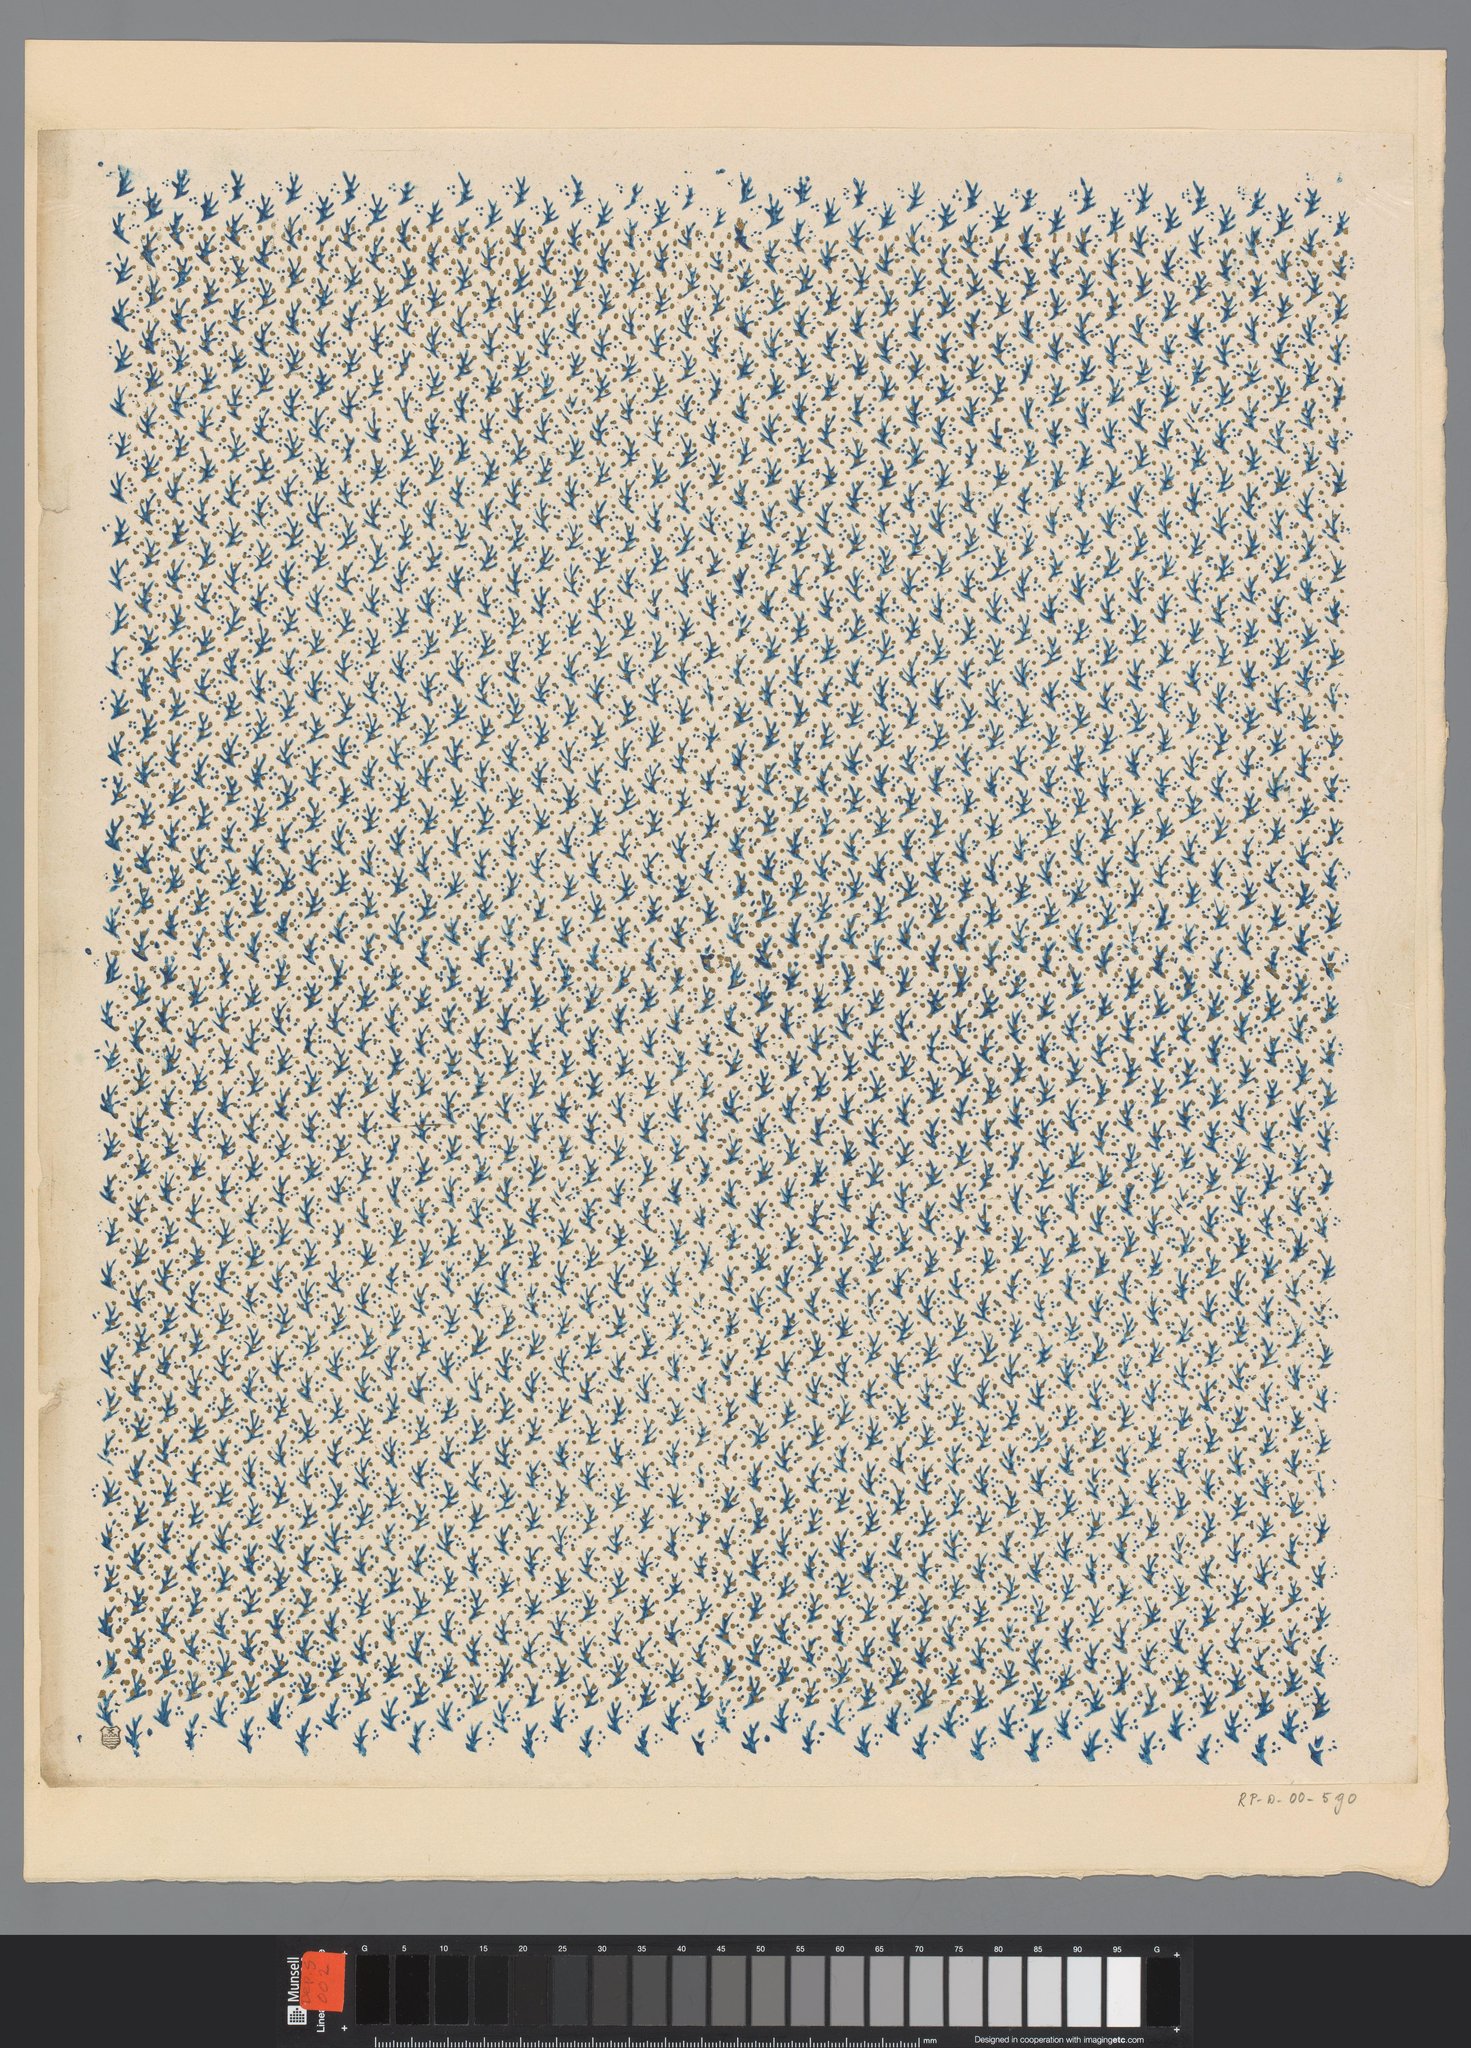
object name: printed paper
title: Blad met strooipatroon van takmotief en punten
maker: Anonymous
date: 1800-1900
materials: paint, paper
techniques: printing block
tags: ornament derived from plant forms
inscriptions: collector's mark: Lugt 2760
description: Blad met strooipatroon van takmotief en punten.